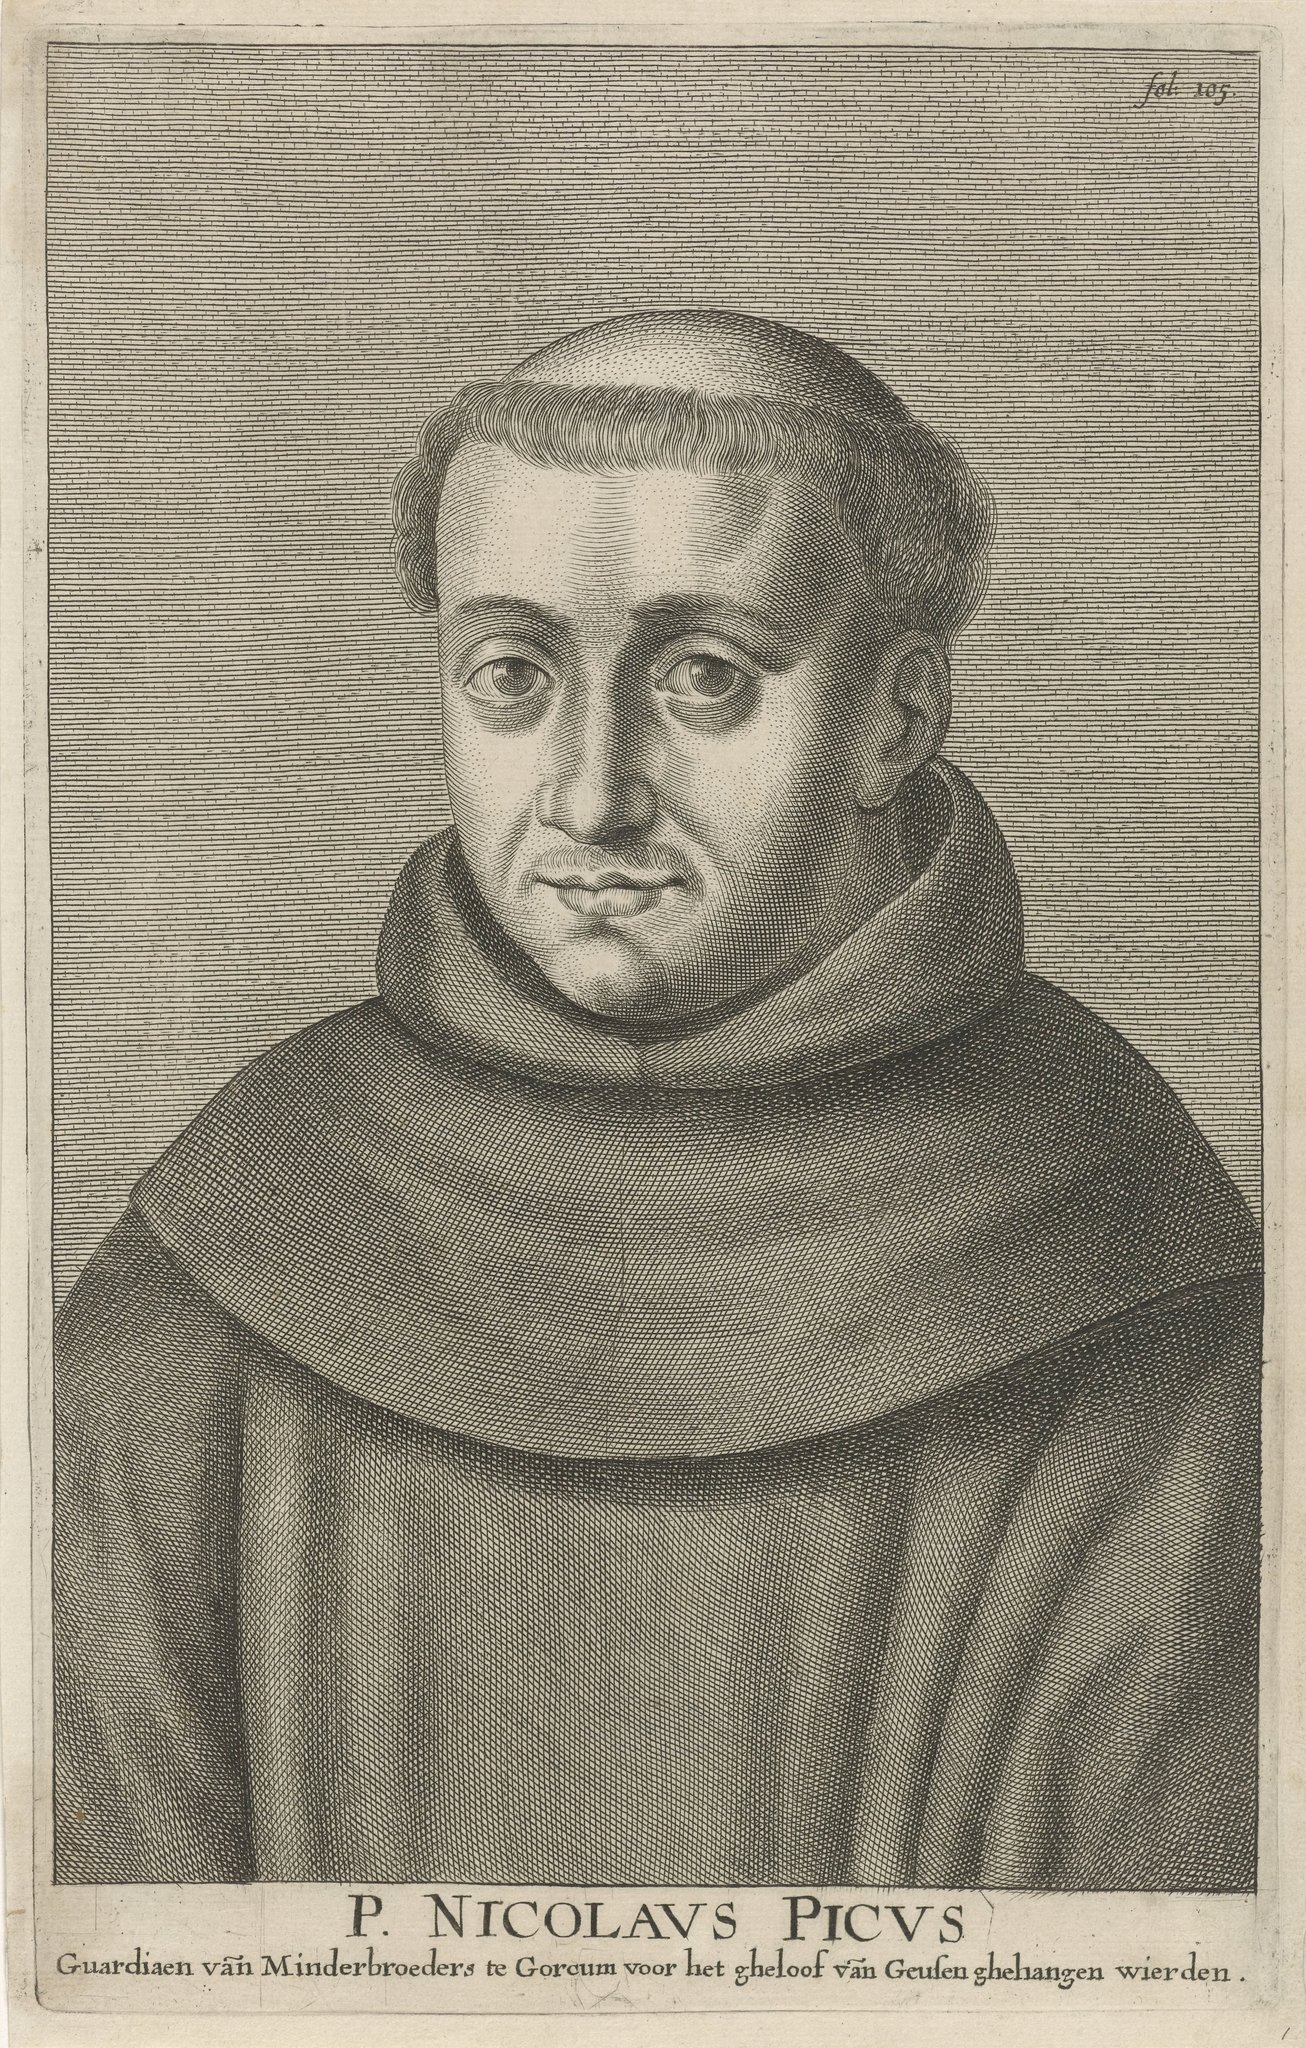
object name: print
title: Portret van Nicolaus Picus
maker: adriaen lommelin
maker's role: print maker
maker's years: 1618-1675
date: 1630-1677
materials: paper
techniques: engraving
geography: antwerp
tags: brielle, martyrs of gorkum, historical persons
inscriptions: collector's mark: Lugt 2228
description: Portret van Nicolaus Picus, franciscaner priester, theoloog en omstreeks 1568 benoemd tot gardiaan van het minderbroederklooster van Gorinchem. Een van de negentien Martelaren van Gorcum. Prent rechtsboven gemerkt: Fol. 105.